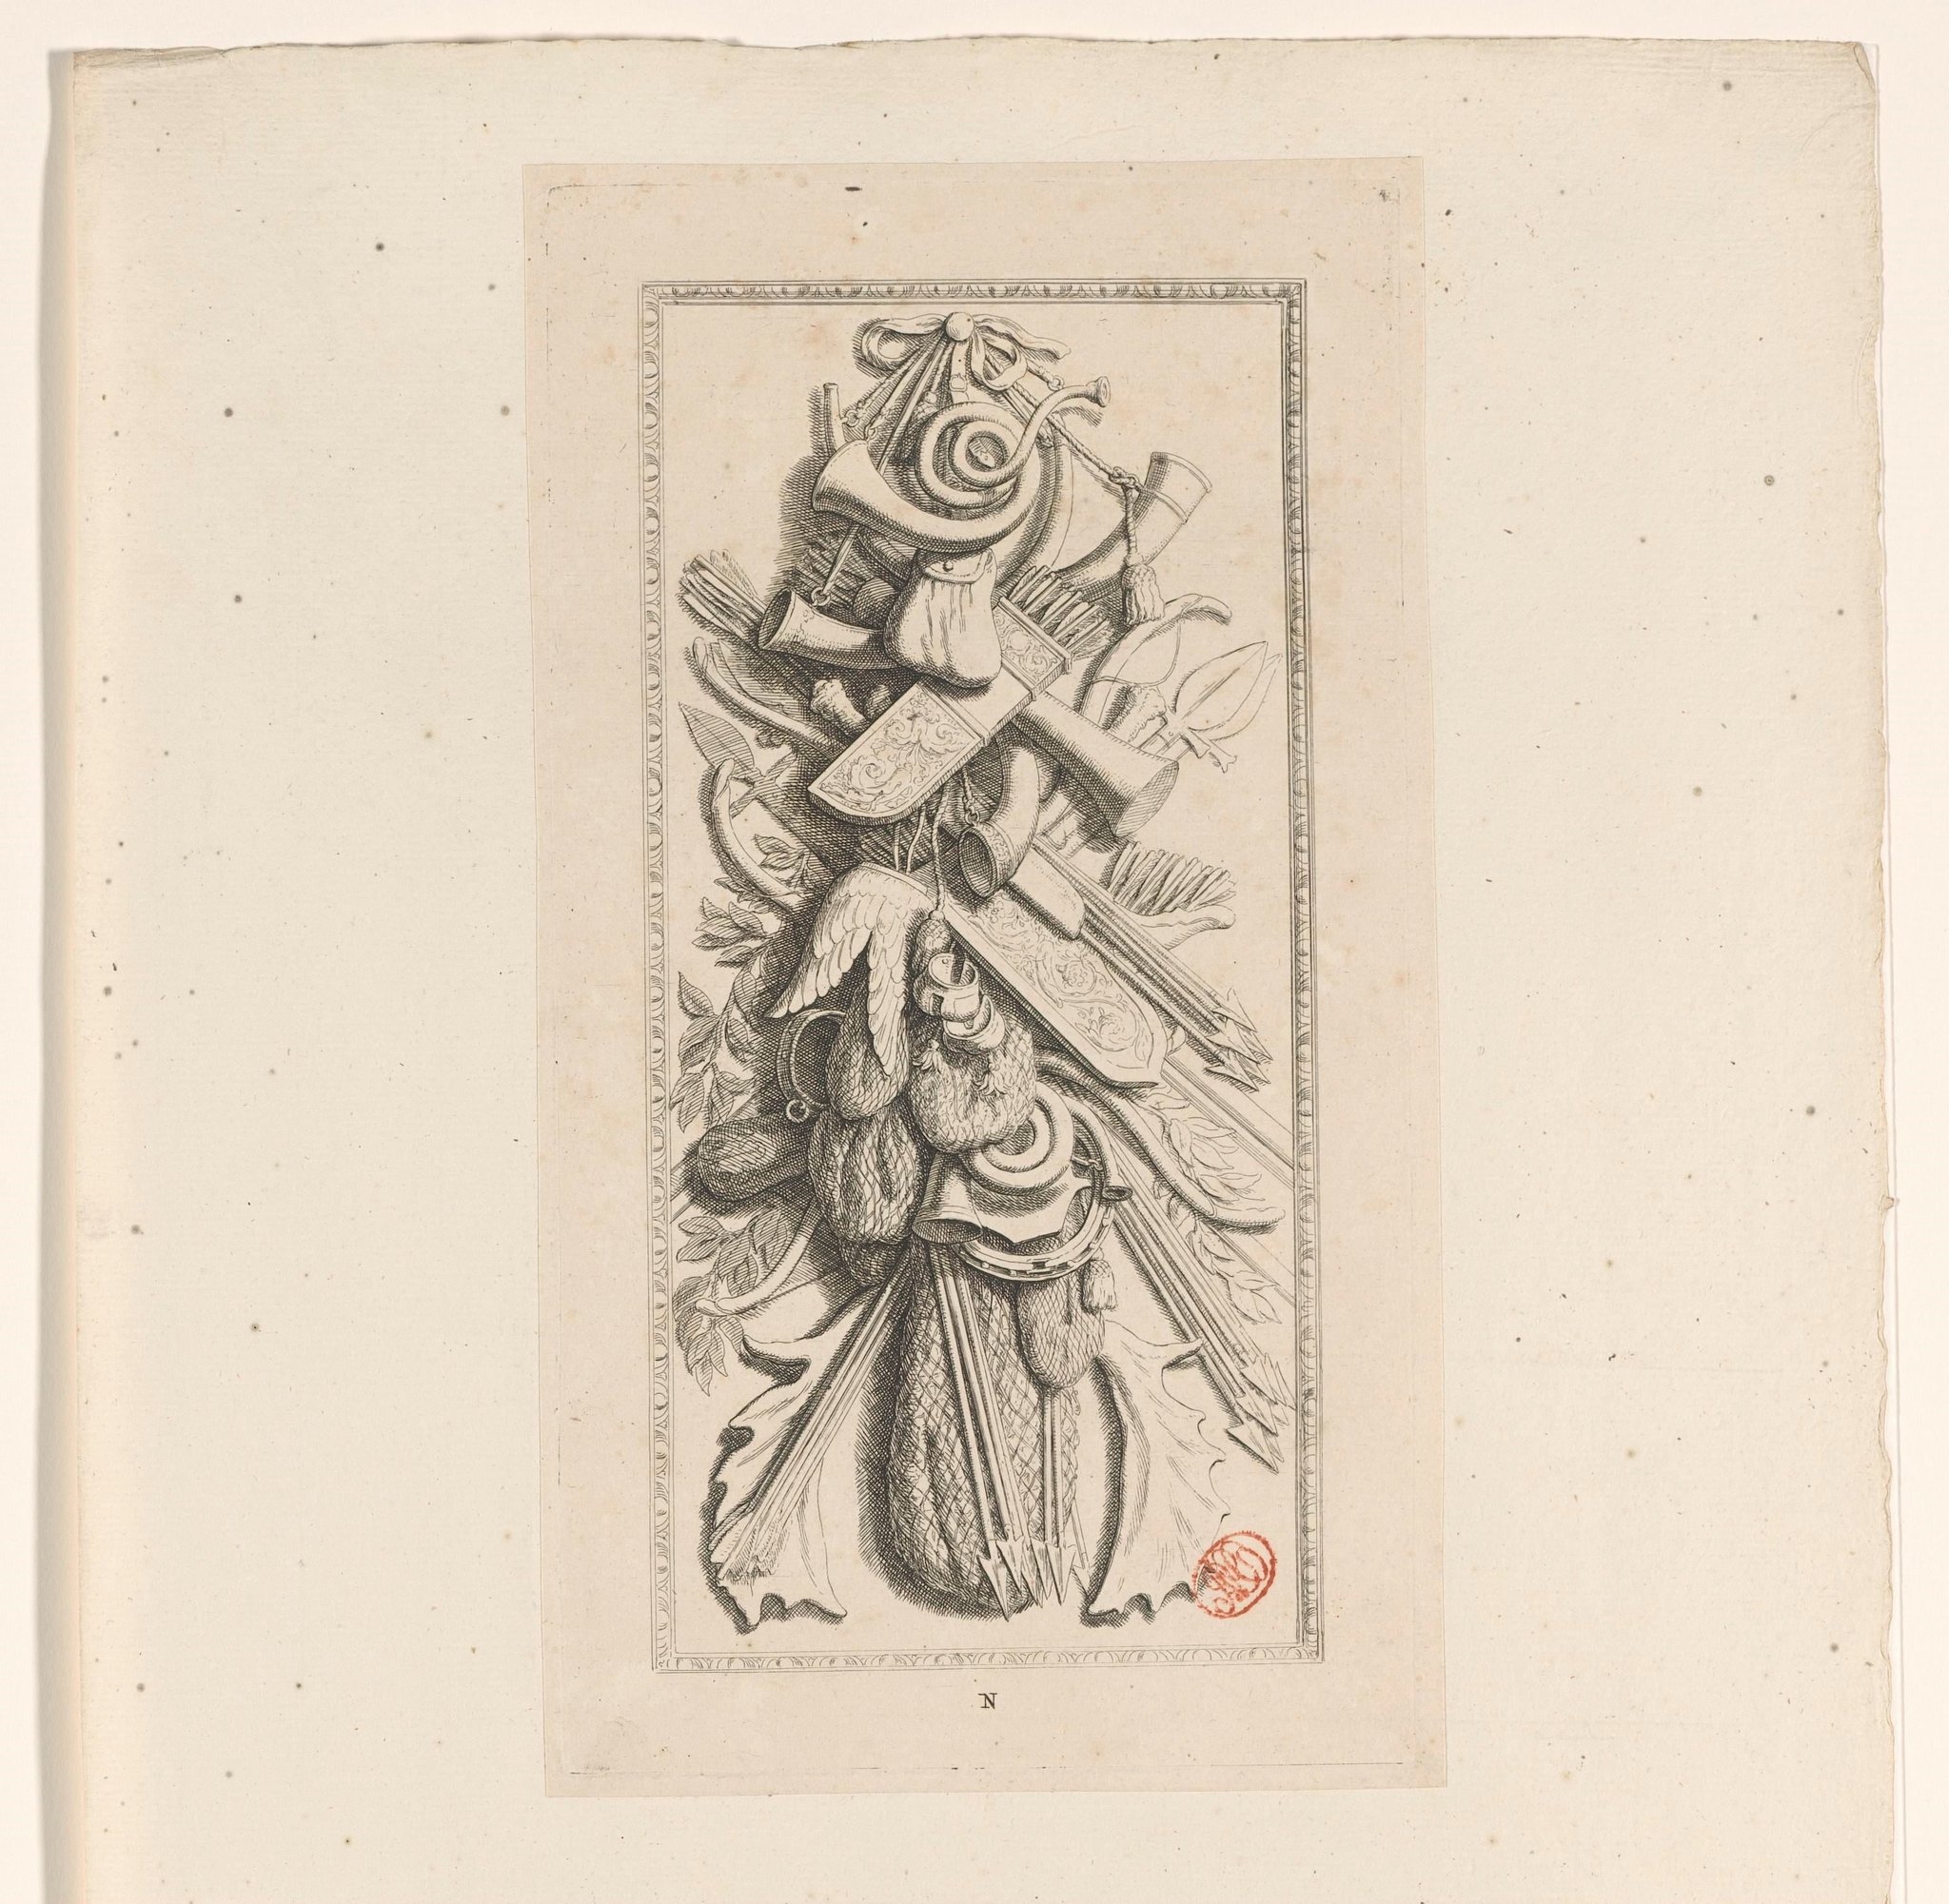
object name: book illustration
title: Reliëf met jacht- en visattributen voor op piëdestal in de oostelijke galerij van het Stadhuis op de Dam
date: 1655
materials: paper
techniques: engraving, etching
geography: amsterdam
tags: hunting, chase (+ hunting weapons, equipment, outfit), attributes of diana, fishing (sports) (+ fishing equipment)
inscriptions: collector's mark: Lugt 195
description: Prent gebruikt in: Prima pars. Praecipuarum effigierum ac ornamentorum, amplissimae Curiae Amstelrodamensis (…) / Het eerste deel. Van de voornaemste Statuen ende Ciraten, vant konstijck Stadhuys van Amstelredam, tmeeste in marmer gemaeckt, door Artus Quellinus, Beelthouwer der voorseyde Stadt / La Premier Partie. De plusieurs Figures et ornements, de la Maison de Ville d'Amsterdam (…). Amsterdam: Artus Quellinus (I), 1655. Zie RP-P-AO-22-1-1 voor bijhorende titelpagina. Zie RP-P-AO-22-1-2 voor bijhorend register. Zie RP-P-AO-22-1A, RP-P-AO-22-1B, RP-P-AO-22-1C, RP-P-AO-22-1D-1, RP-P-AO-22-1D-2, RP-P-AO-22-1E, RP-P-AO-22-1F, RP-P-AO-22-1G, RP-P-AO-22-1H, RP-P-AO-22-1I, RP-P-AO-22-1K-1, RP-P-AO-22-1K-2, RP-P-AO-22-1K-3, RP-P-AO-22-1K-4, RP-P-AO-22-1K-5, RP-P-AO-22-1L-1, RP-P-AO-22-1L-2, RP-P-AO-22-1M-1, RP-P-AO-22-1M-2, RP-P-AO-22-1N-1, RP-P-AO-22-1N-2, RP-P-AO-22-1N-3, RP-P-AO-22-1N-5, RP-P-AO-22-1O-1, RP-P-AO-22-1O-2, RP-P-AO-22-1O-3, RP-P-AO-22-1O-4, RP-P-AO-22-1P-1, RP-P-AO-22-1P-2, RP-P-AO-22-1P-3, RP-P-AO-22-1P-4, RP-P-AO-22-1Q-1, RP-P-AO-22-1Q-2, RP-P-AO-22-1Q-3, RP-P-AO-22-1Q-4, RP-P-AO-22-1R-1, RP-P-AO-22-1R-2, RP-P-AO-22-1R-3, RP-P-AO-22-1R-4, RP-P-AO-22-1R-5, RP-P-AO-22-1S-1, RP-P-AO-22-1S-2, RP-P-AO-22-1S-3, RP-P-AO-22-1S-4, RP-P-AO-22-1S-5, RP-P-AO-22-1T-1 en RP-P-AO-22-1T-2 voor andere prenten uit deze publicatie. Zelfde staat van prent ook gebruikt in: Prima pars. Praecipuarum effigierum ac ornamentorum, amplissimae Curiae Amstelrodamensis (…) / Het eerste deel. Van de voornaemste Statuen ende Ciraten, vant konstijck Stadhuys van Amstelredam, tmeeste in marmer gemaeckt, door Artus Quellinus, Beelthouwer der voorseyde Stadt / La Premier Partie. De plusieurs Figures et ornements, de la Maison de Ville d'Amsterdam (…). Amsterdam: Frederik de Wit, 1665. Latere staat van prent ook gebruikt in: Architecture peinture et sculpture de la Maison de Ville d'Amsterdam, representee en CIX. figures en taille-douce (…). Amsterdam: David Mortier, 1719. En in: Architecture peinture et sculpture de la Maison de Ville d'Amsterdam, representee en CIX. figures en taille-douce (…). Amsterdam: Gerard Valck, 1719. En in: Bouw schilder en beeldhouwkonst, van het Stadhuis te Amsteldam, vertoont in CIX figuuren (…). Amsterdam: Covens & Mortier & Covens Jr., s.a. (1774-1783).